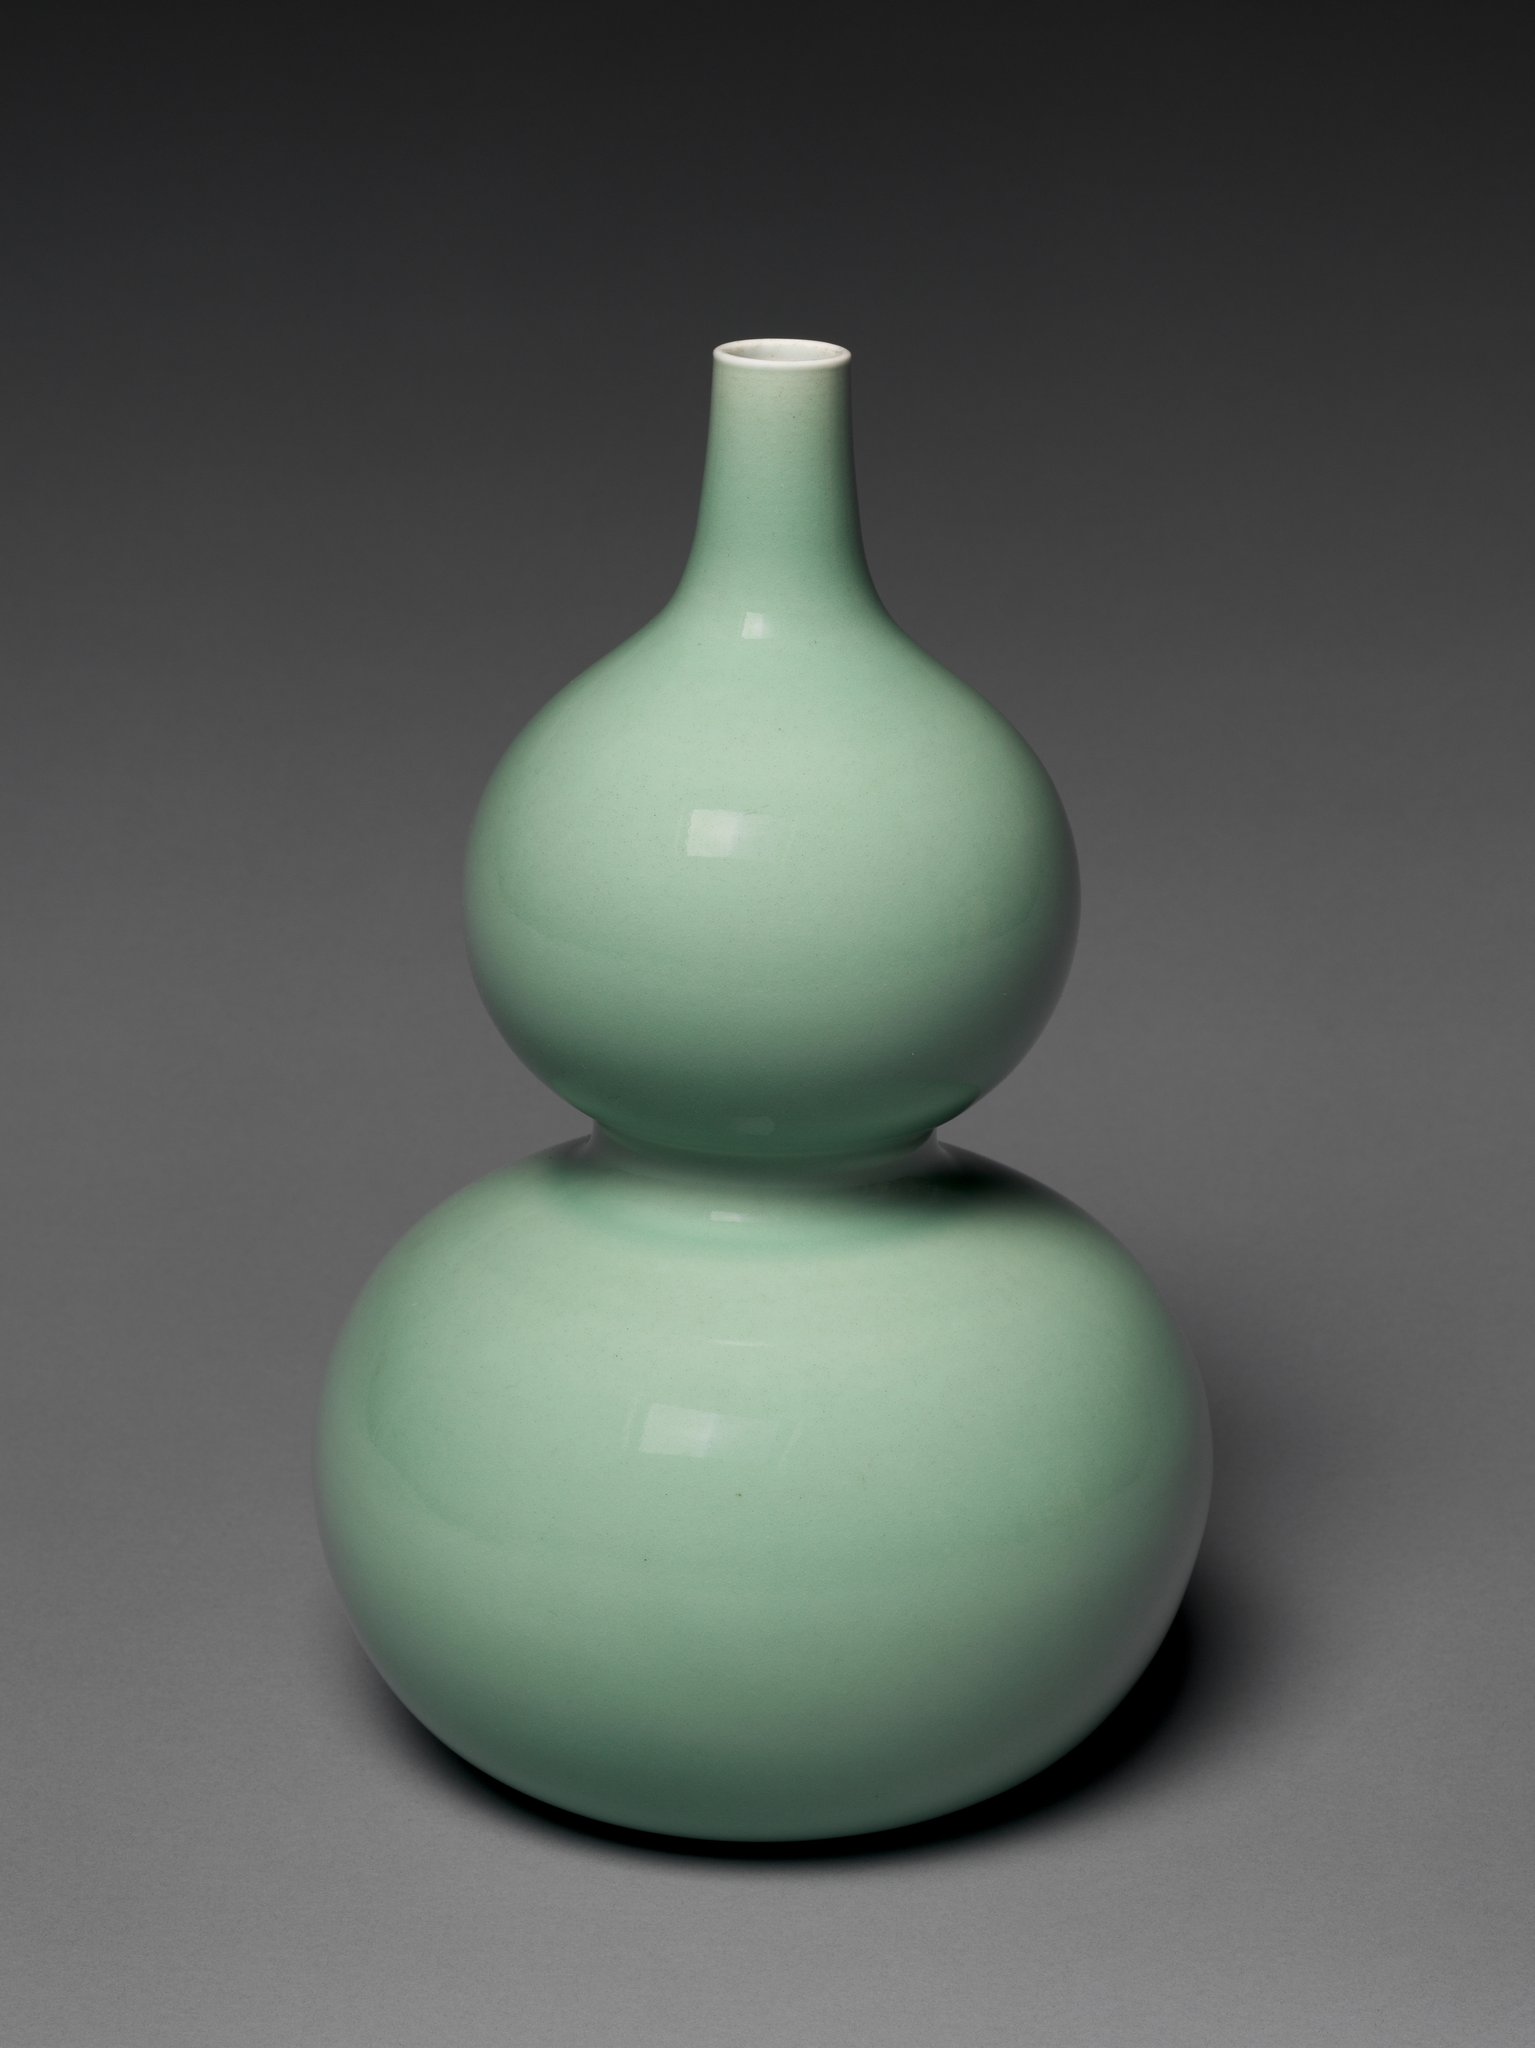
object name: bottle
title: Gourd-Shaped Bottle (one of a pair)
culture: chinese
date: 1701-1800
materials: ceramic glaze, glaze, porcelain